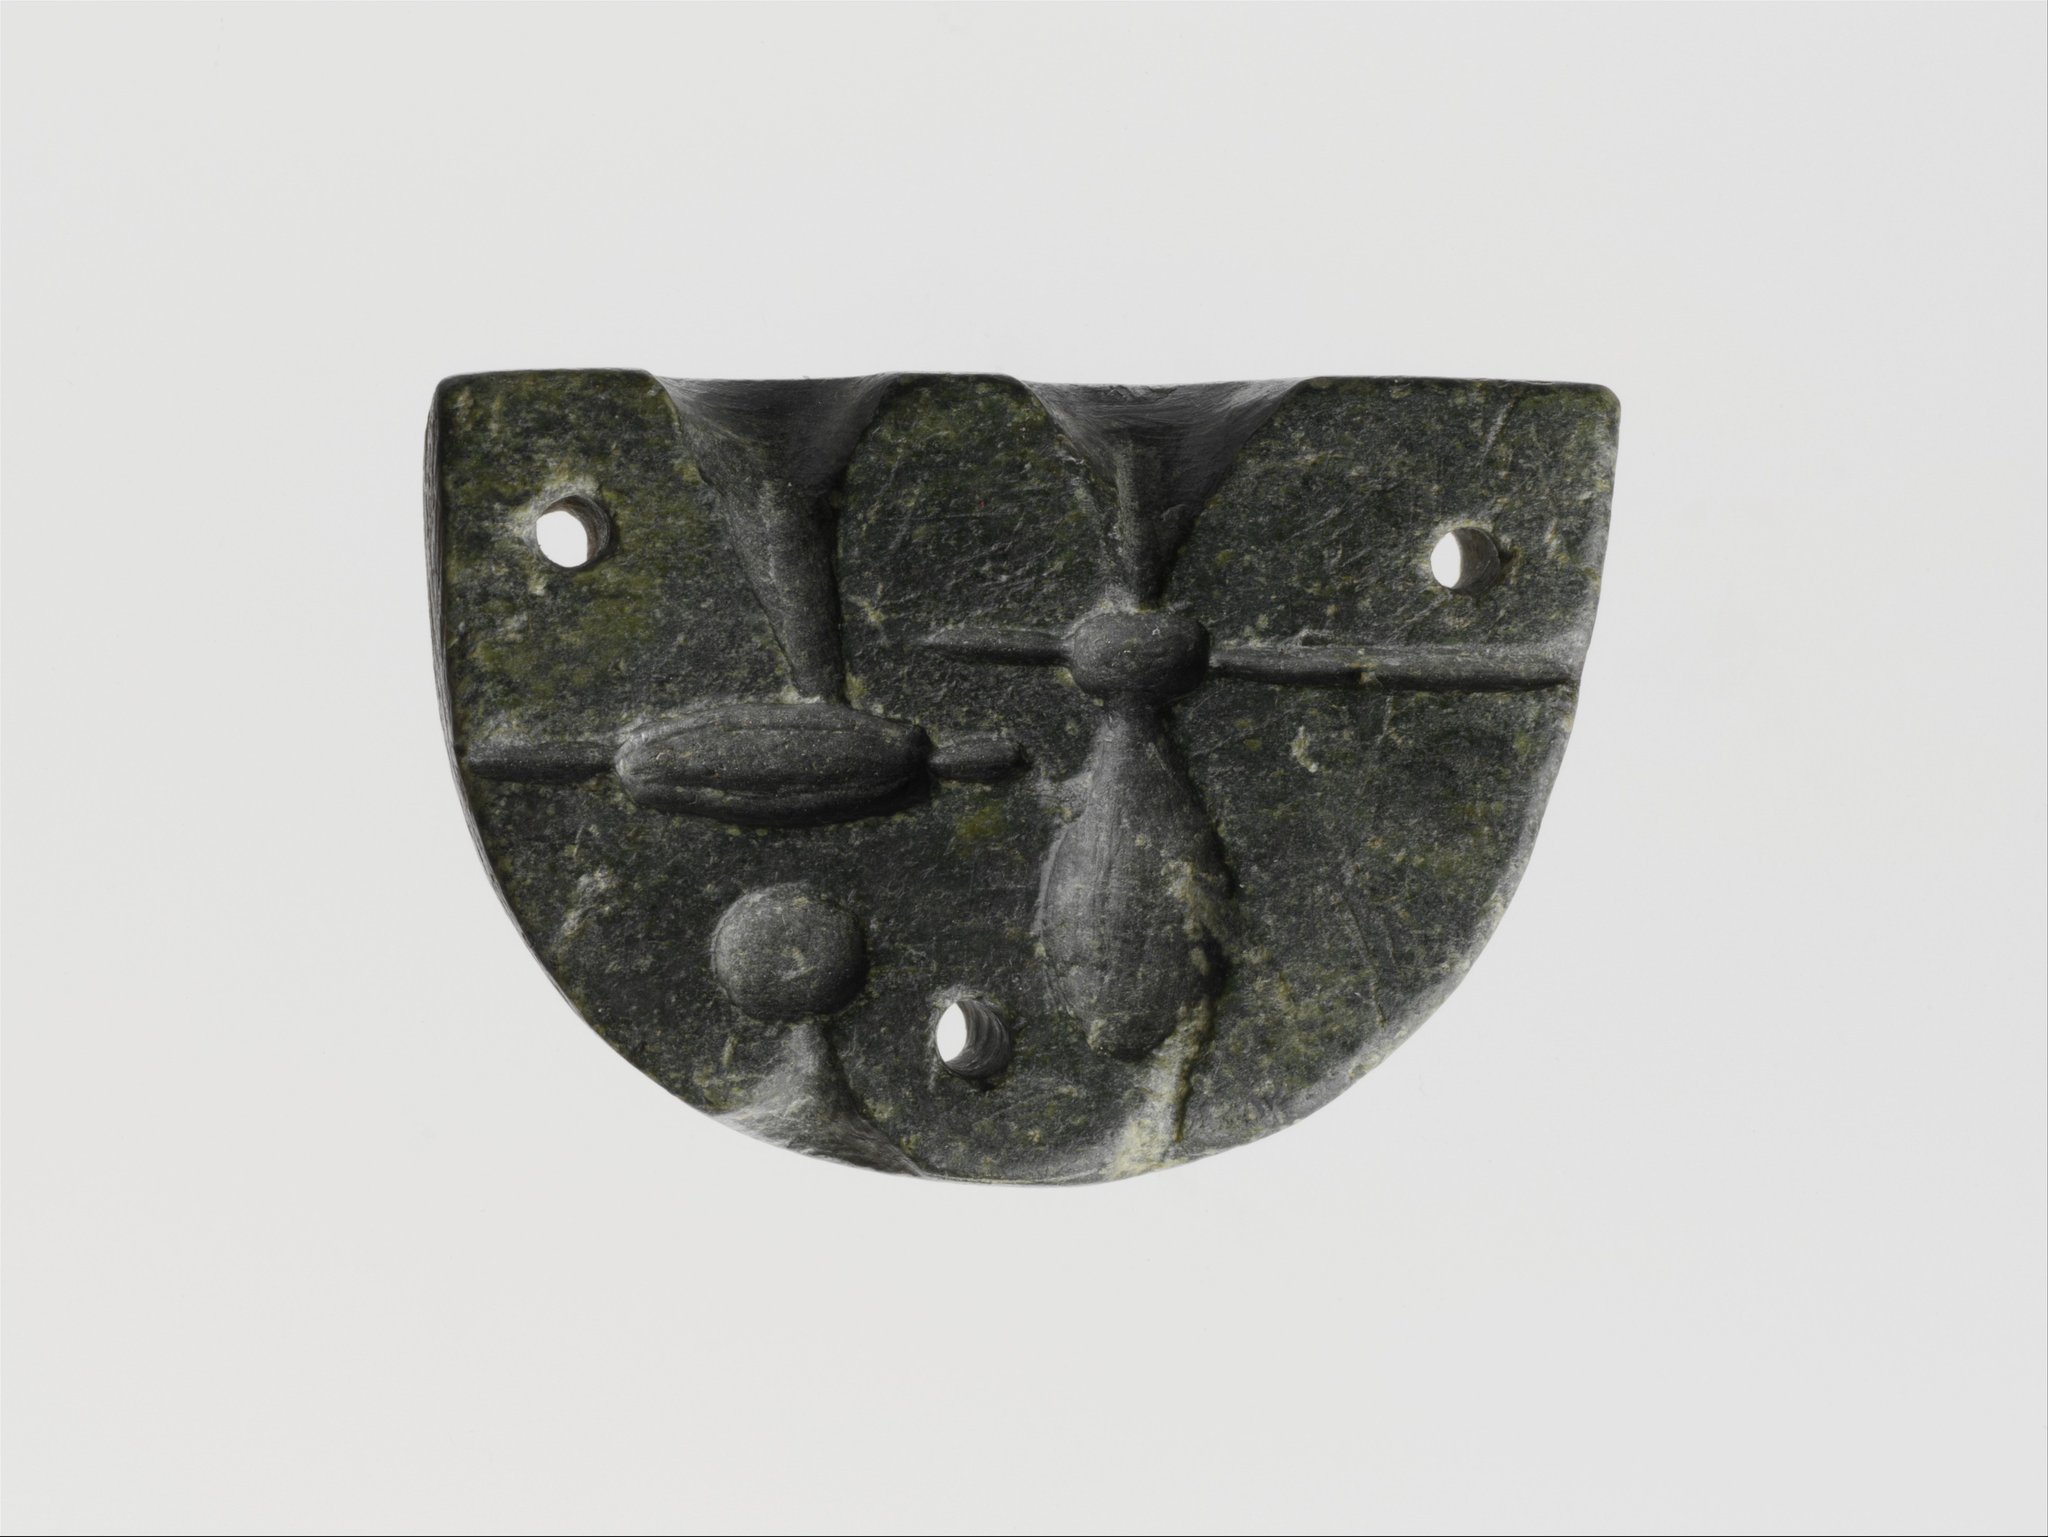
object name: mold for casting bead pendant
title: Serpentine mold for casting bead pendants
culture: minoan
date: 1600-1400 BCE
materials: stone